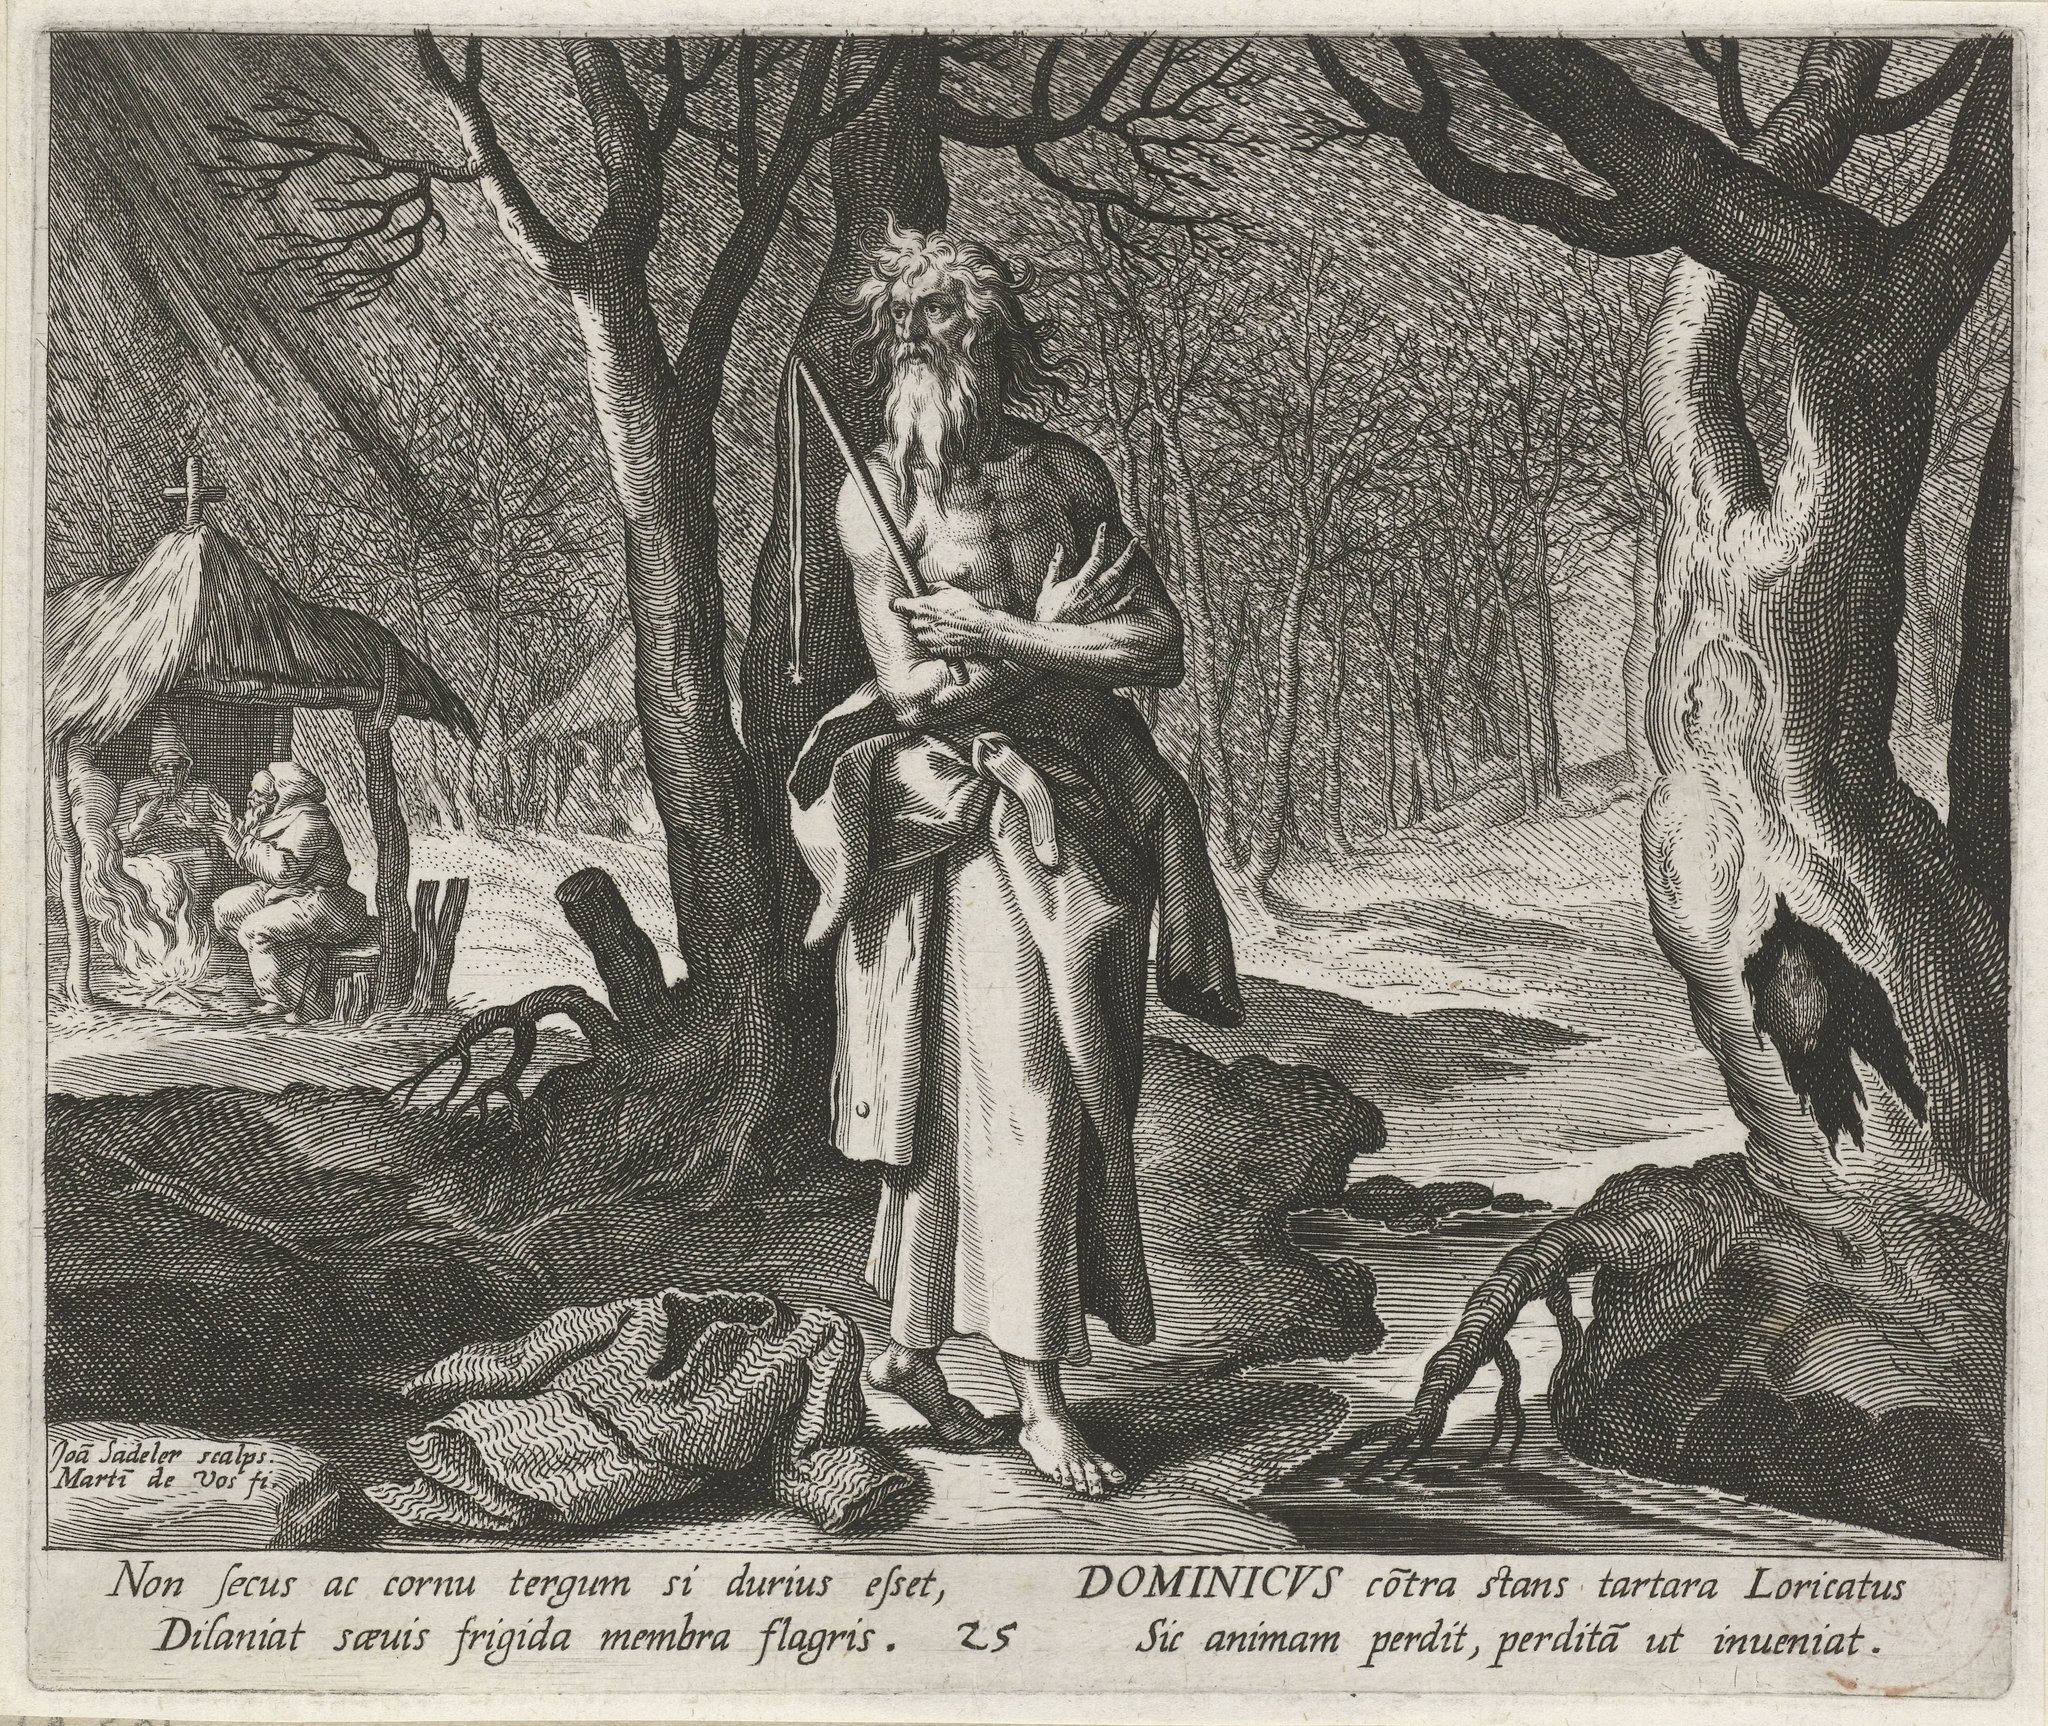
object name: print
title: Mannelijke kluizenaars en heremieten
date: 1594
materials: paper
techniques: engraving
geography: munich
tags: male saints (with name), self-castigation ~ ascetic life, forest, wood, anchorite, hermit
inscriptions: collector's mark: Lugt 240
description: De H. Dominicus Loricatus, een Italiaanse kluizenaar uit de elfde eeuw na Christus. Hij staat half naakt op de voorgrond en heeft een gesel in de linkerhand. Op de achtergrond een boslandschap met enkele monniken in een hut.